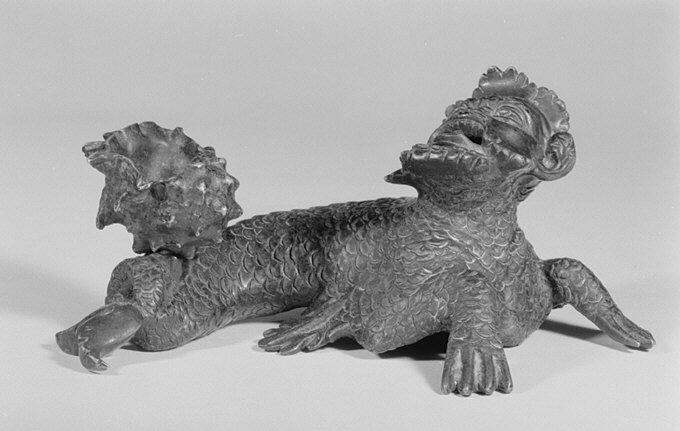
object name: statuette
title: Dragon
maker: severo calzetta da ravenna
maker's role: artist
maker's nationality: italian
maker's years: 1496-1543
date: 1801-2000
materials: bronze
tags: dragons